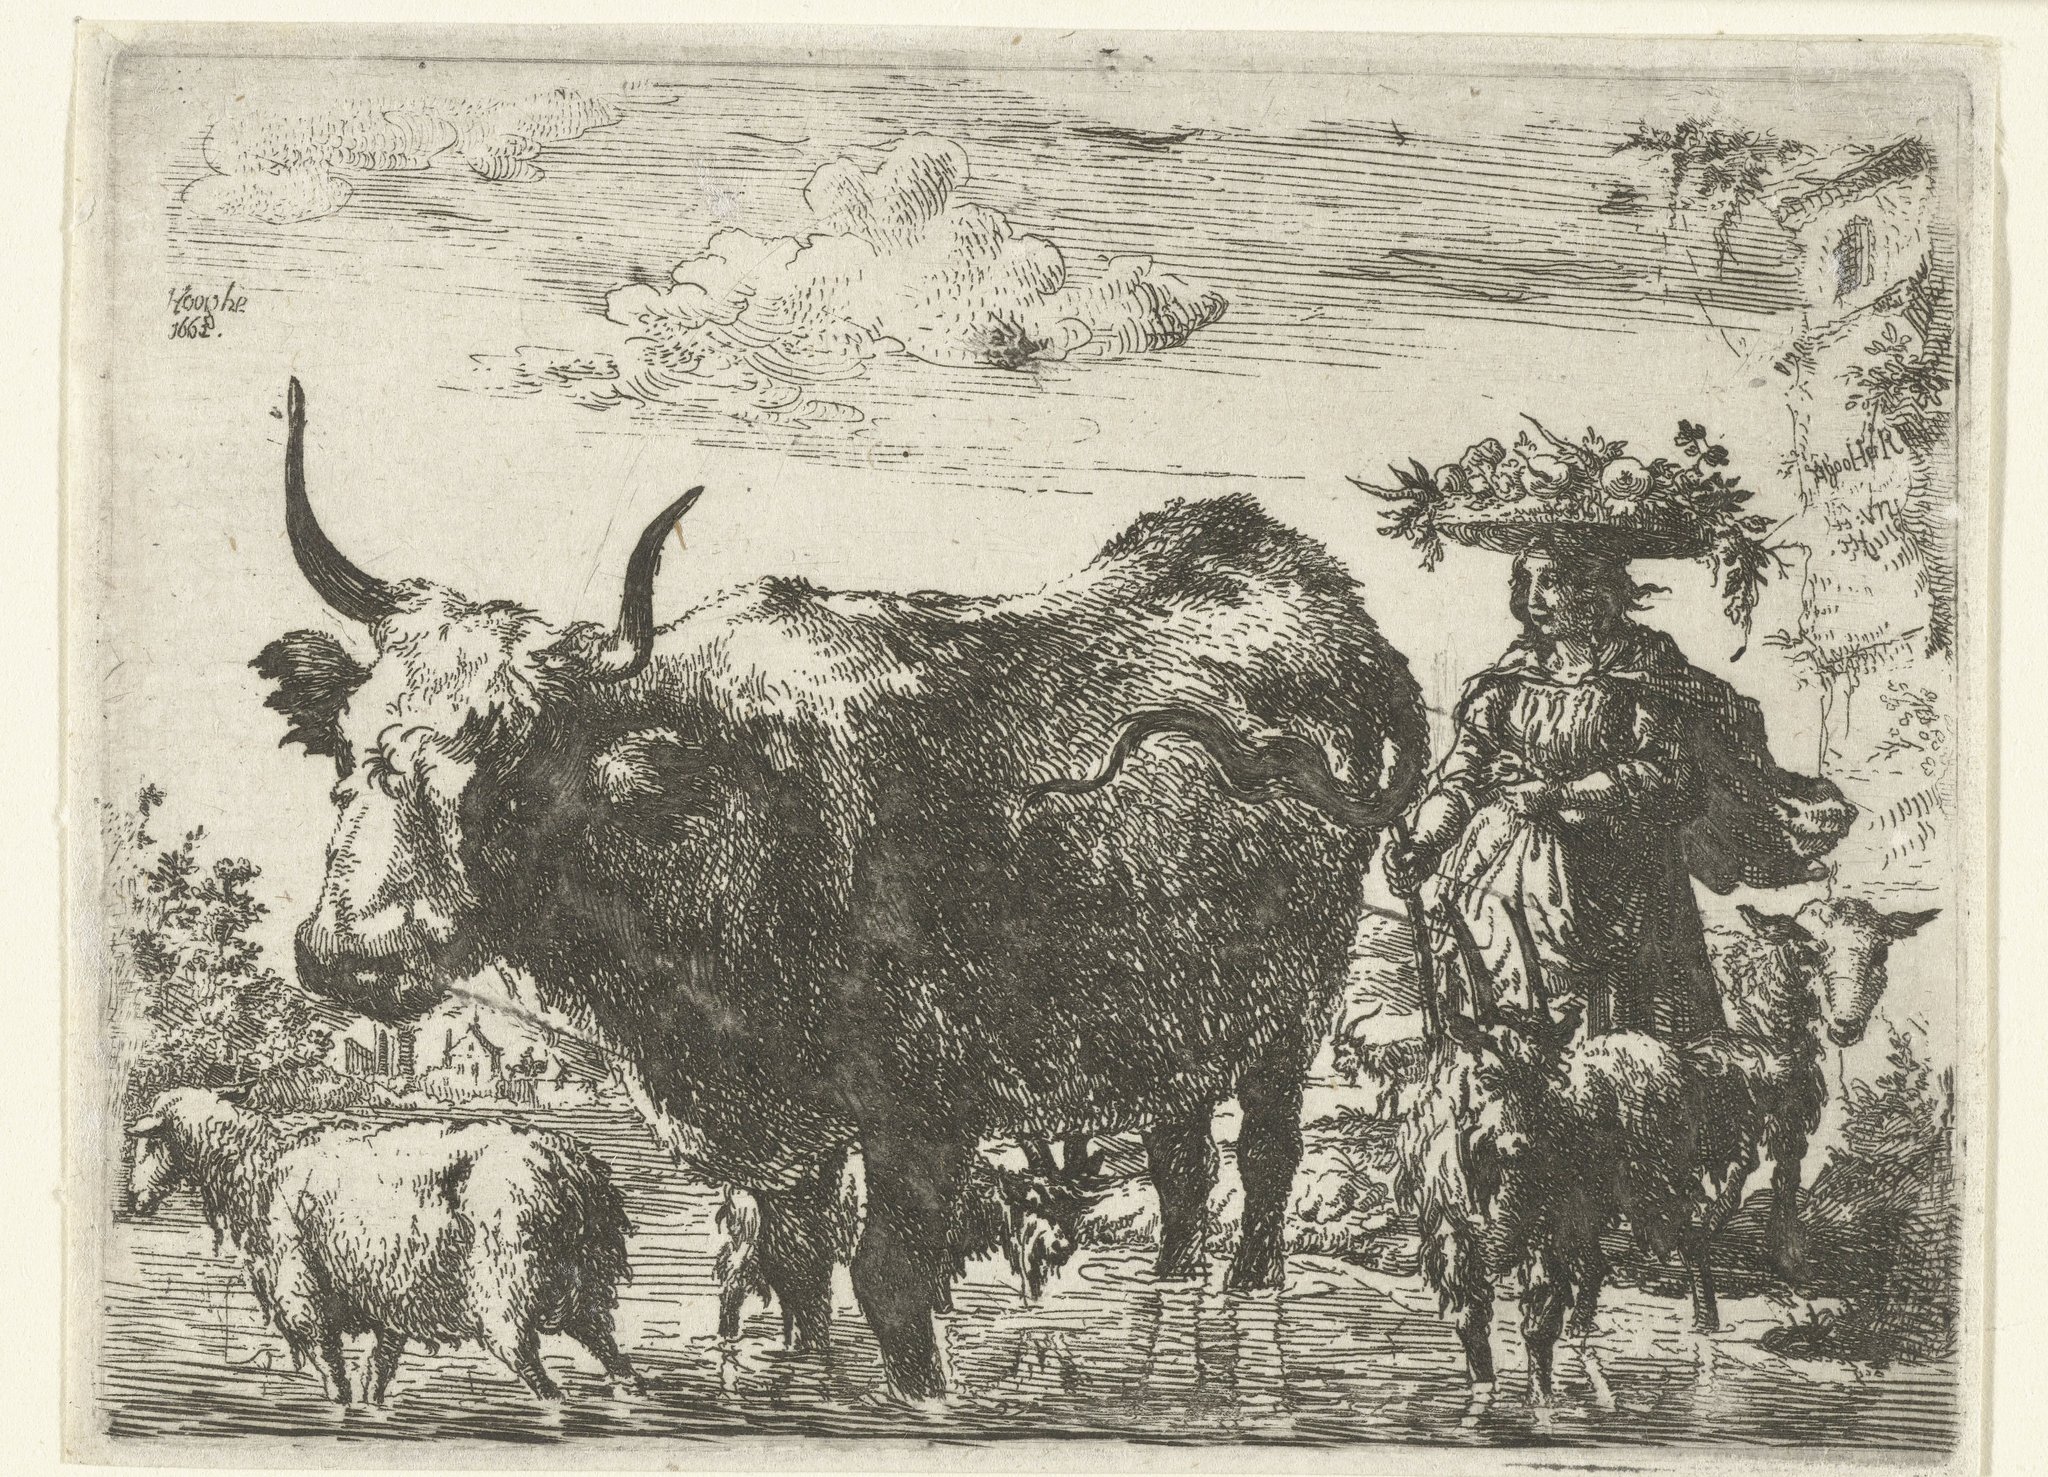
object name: print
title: Herderin met mand op het hoofd, een koe, twee geiten en twee schapen in het water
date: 1662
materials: paper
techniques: etching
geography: netherlands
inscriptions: date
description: Herderin met mand op het hoofd, een koe, twee geiten en twee schapen in het water